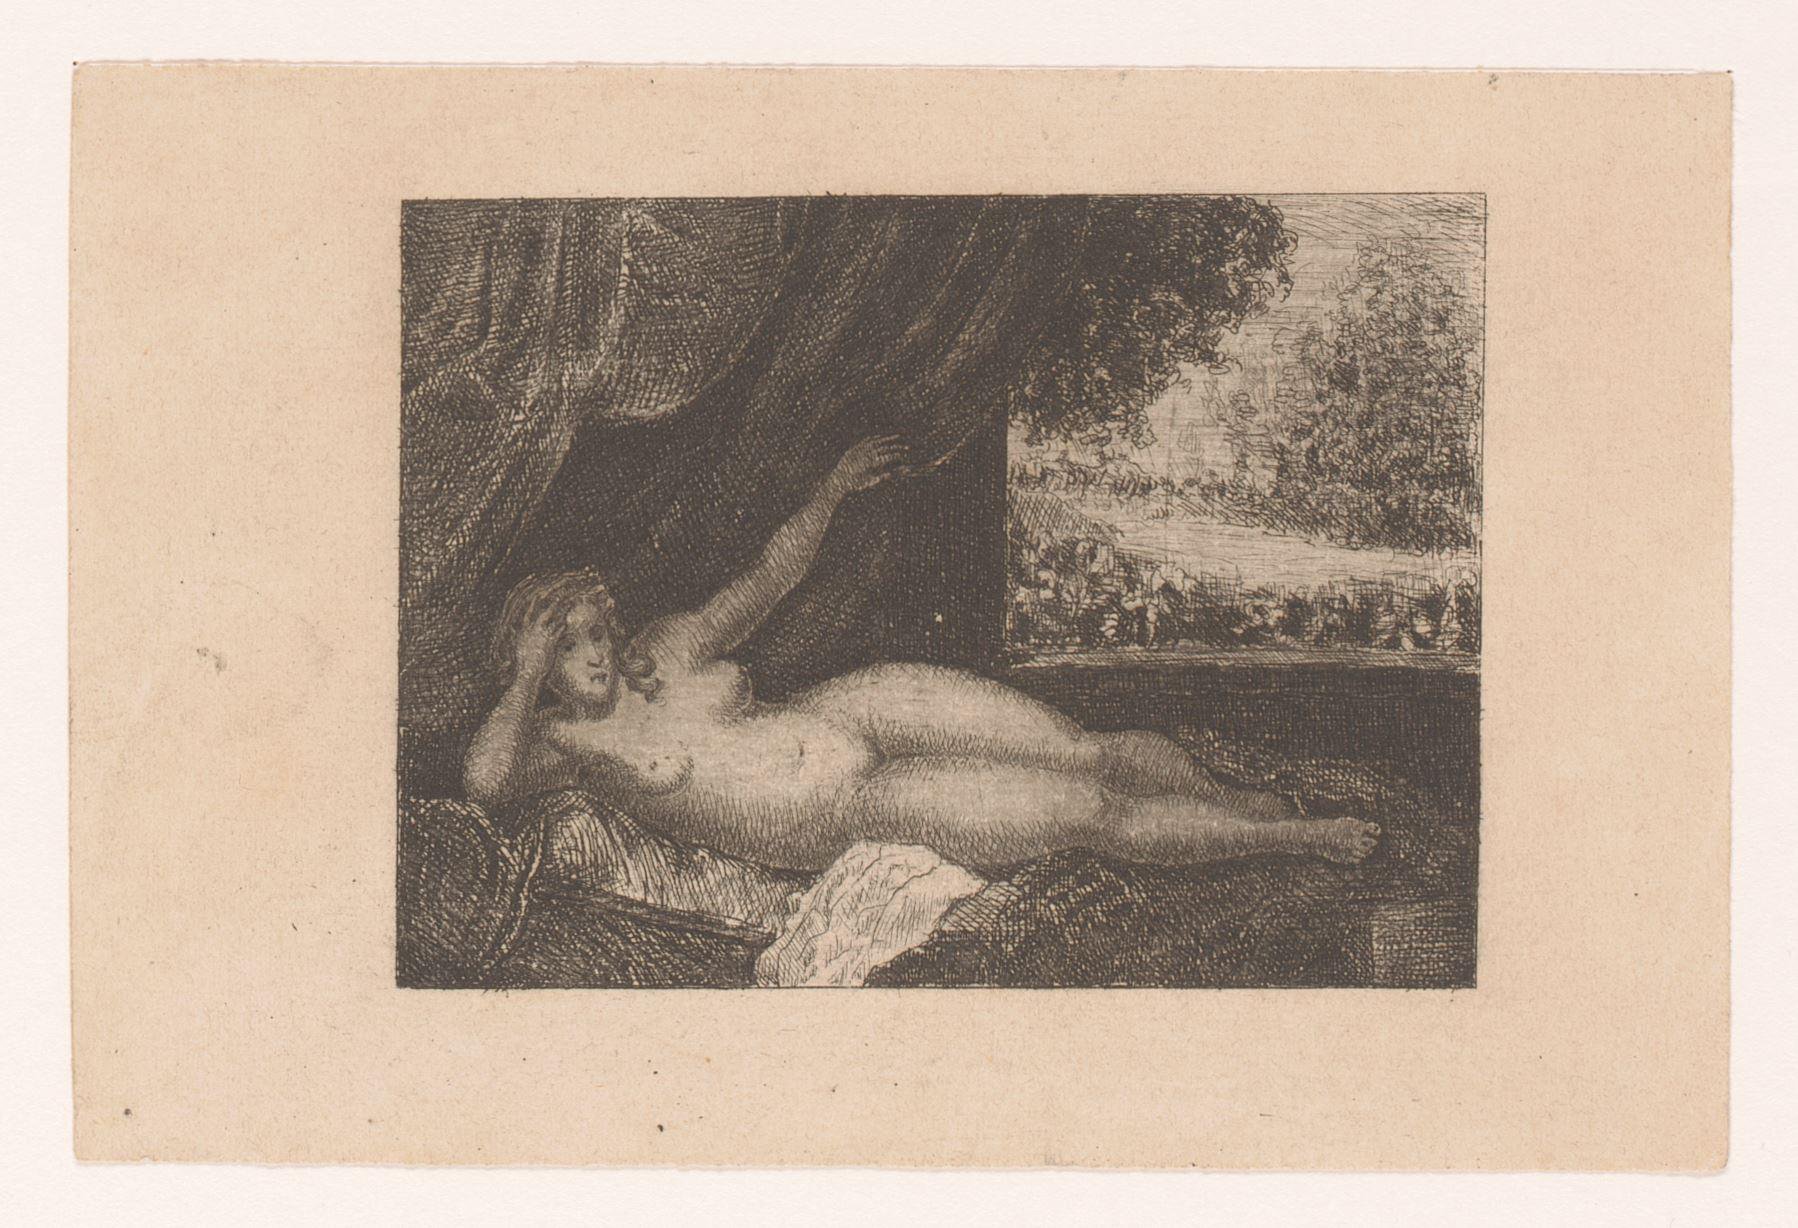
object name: print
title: Liggende naakte vrouw op een rustbed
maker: ernst buschmann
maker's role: bookseller, print maker, printer, publisher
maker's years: 1814-1853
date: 1824-1853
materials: paper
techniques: etching, intaglio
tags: woman (showing herself) undressed, quasi-nude, the (nude) human figure; 'corpo humano' (ripa) - aa - female human figure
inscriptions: collector's mark: Lugt 2228